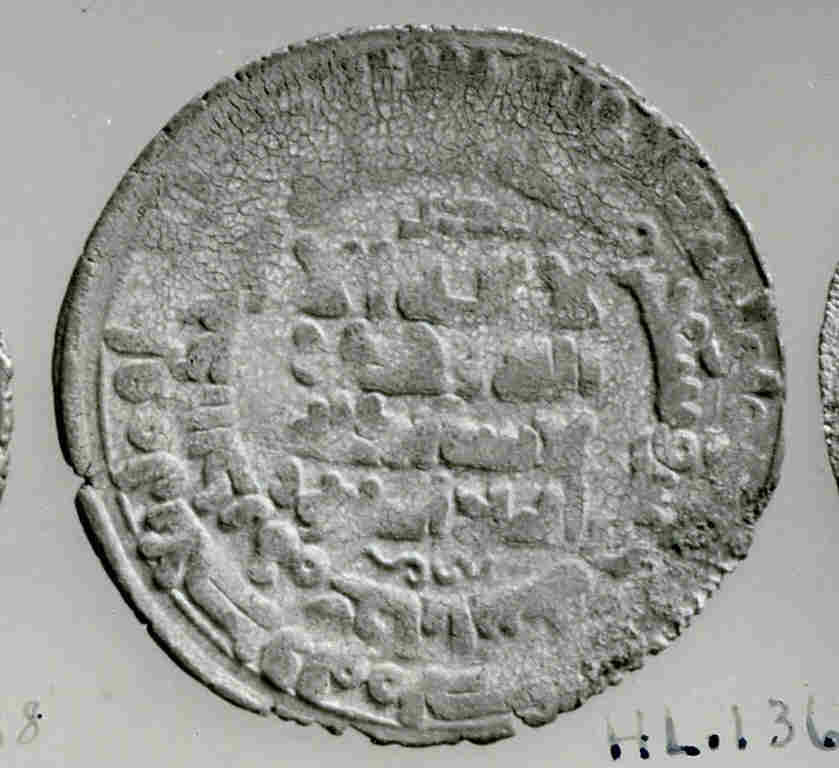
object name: coin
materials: silver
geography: uzbekistan